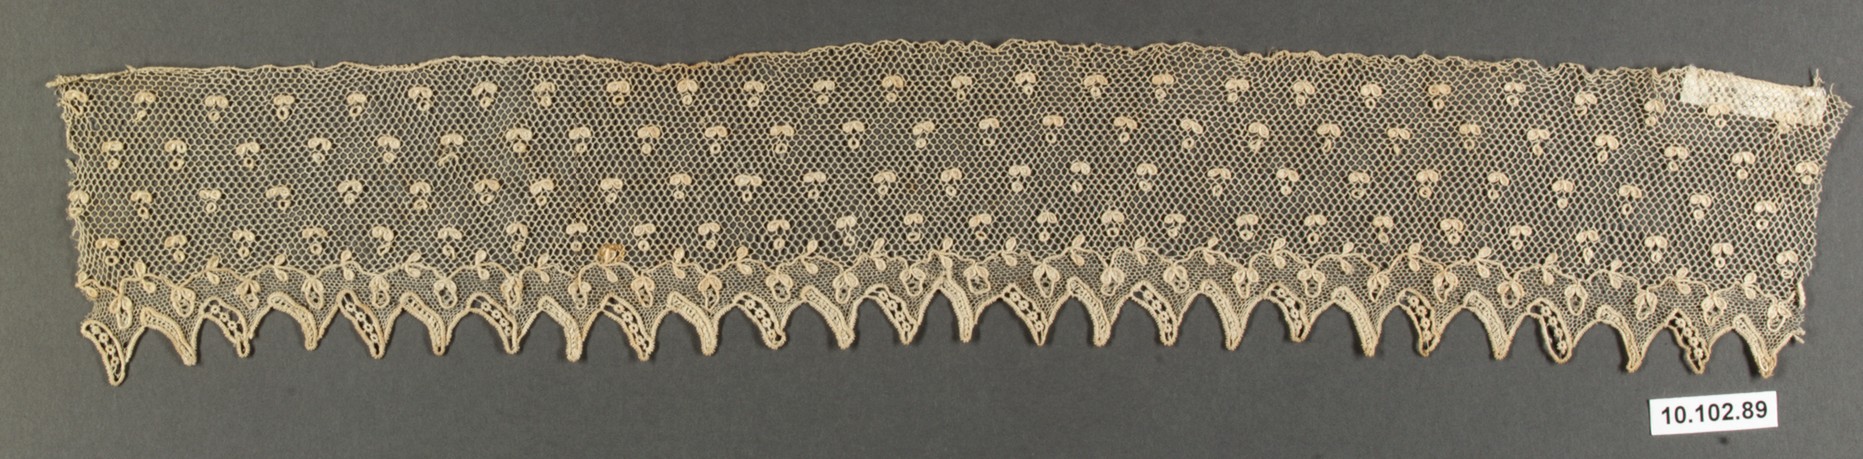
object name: fragment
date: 1801-1900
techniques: lace